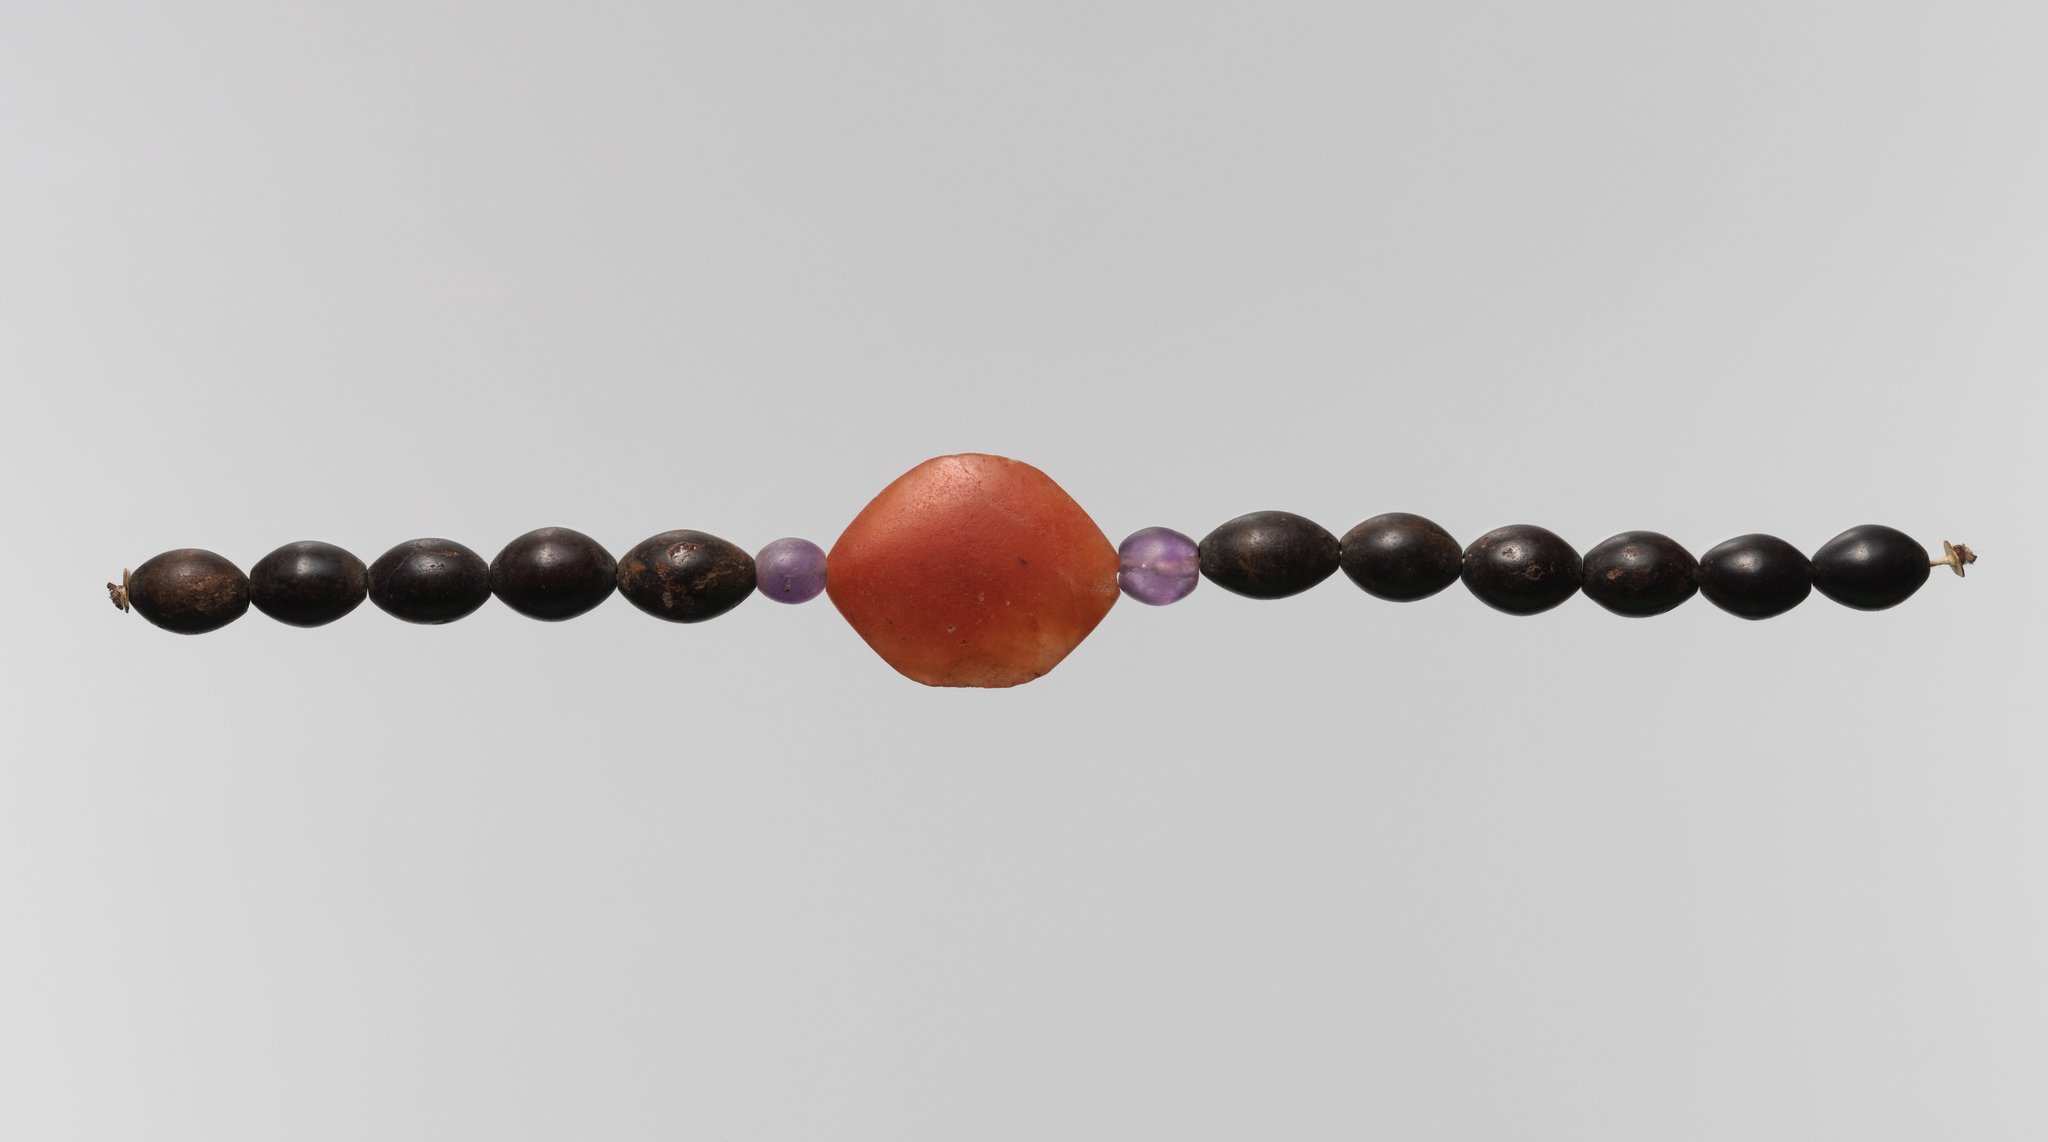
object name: string of barrel bead and one acacia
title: String of beads, barrel and one acacia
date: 2030-1640 BCE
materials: gemstone, mineral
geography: egypt